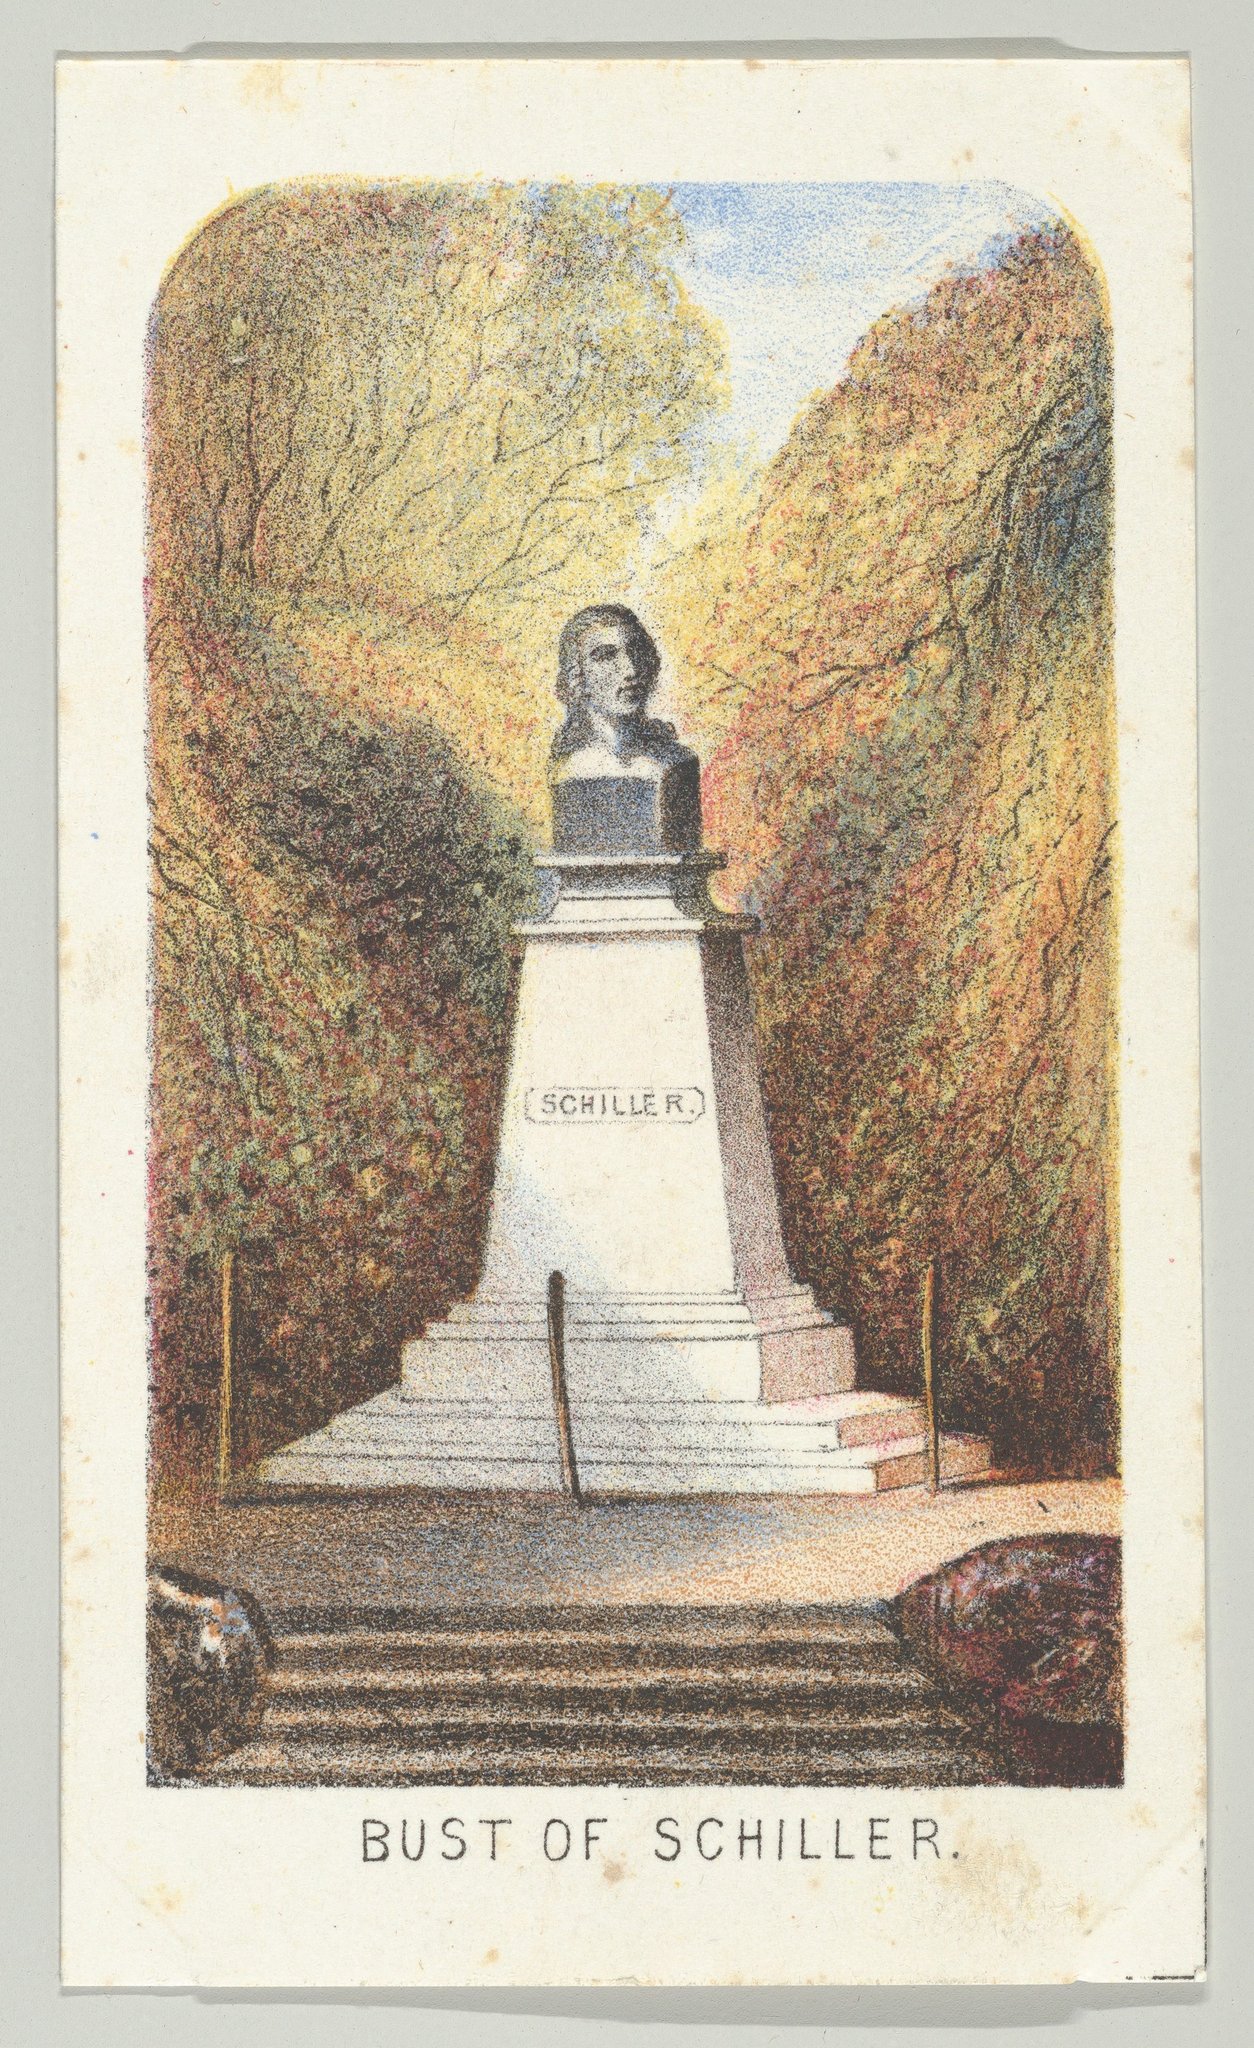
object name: print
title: Bust of Schiller, from the series, Views in Central Park, New York, Part 3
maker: louis prang & co.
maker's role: publisher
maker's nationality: american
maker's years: 1800-1950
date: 1864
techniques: lithograph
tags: men,poets